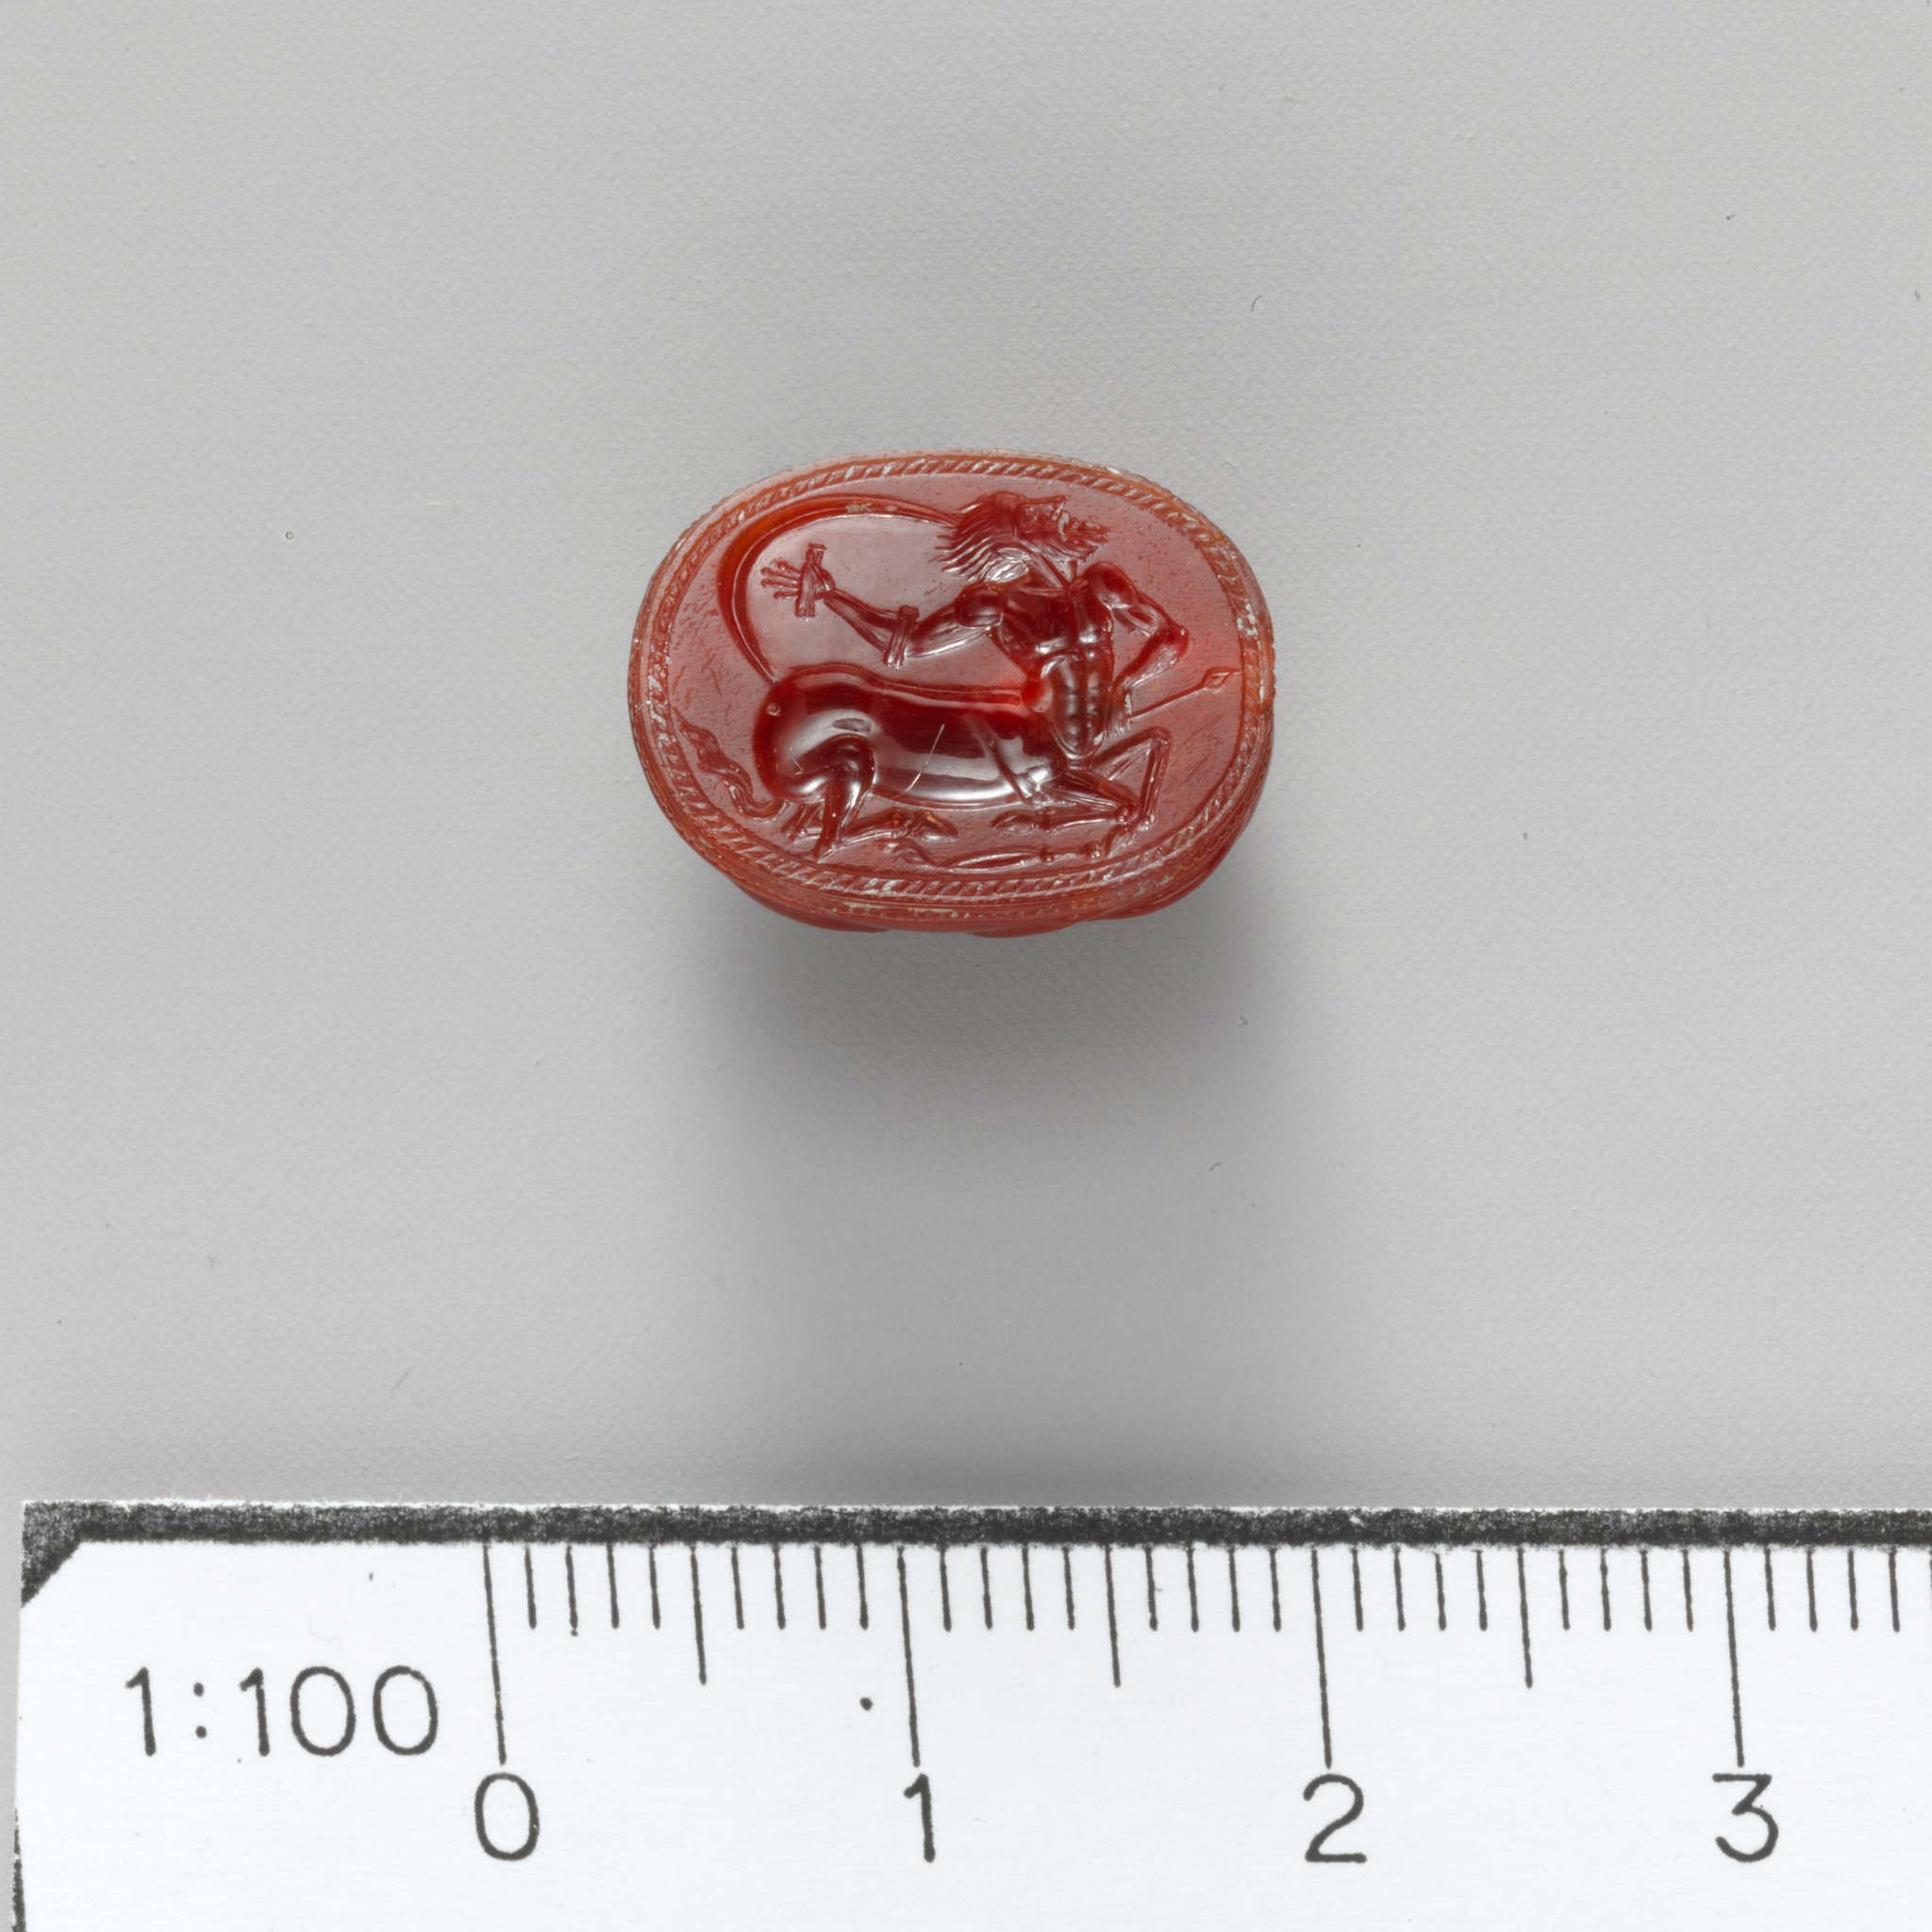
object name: scarab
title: Carnelian scarab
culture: etruscan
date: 450 BCE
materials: gemstone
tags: centaurs